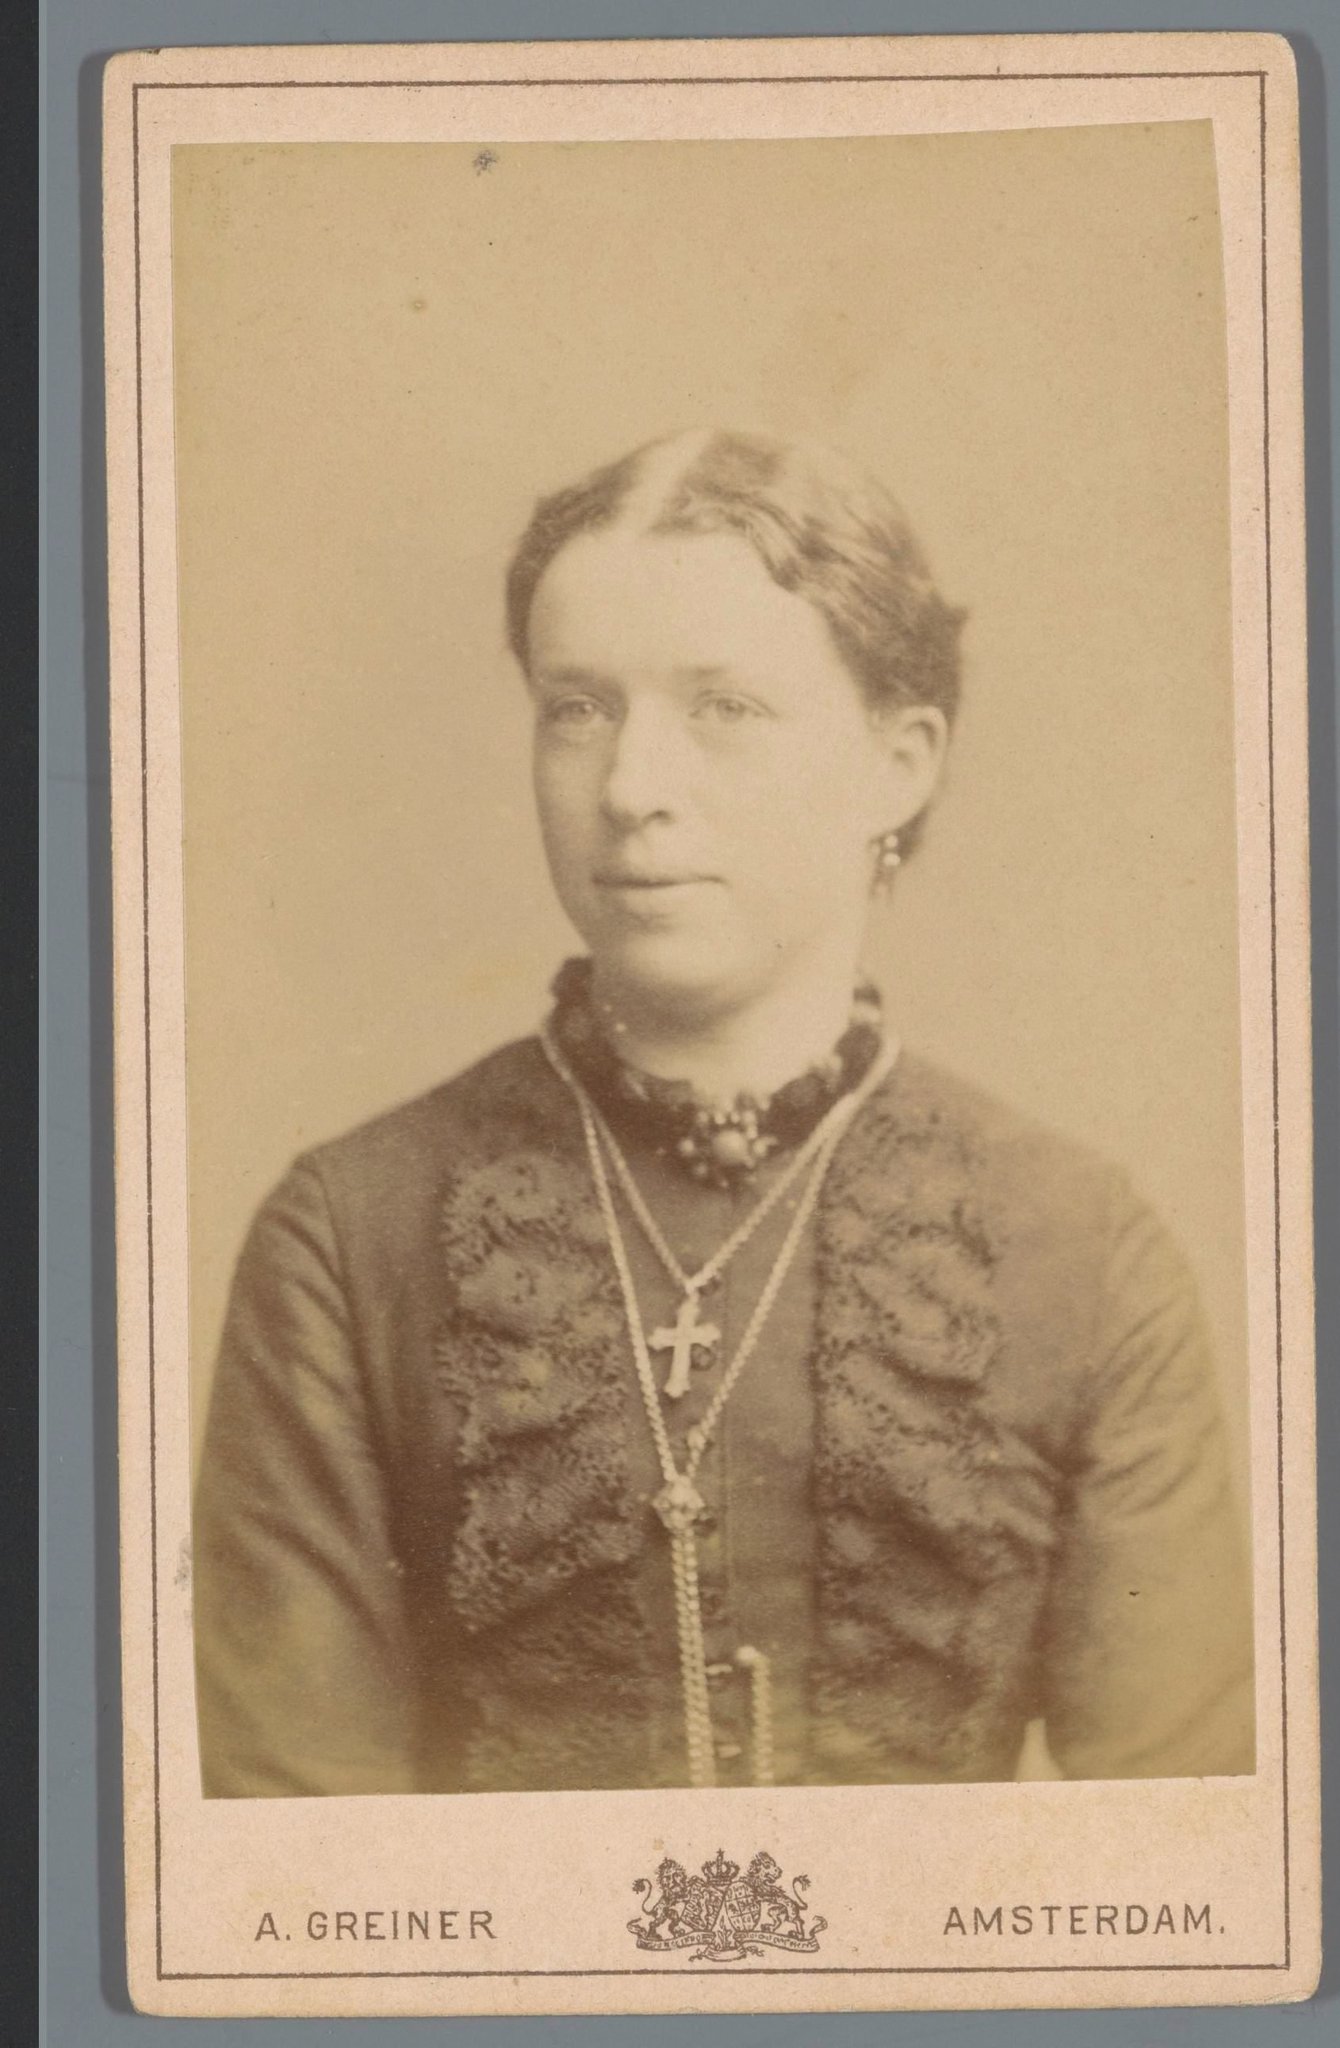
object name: photograph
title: Portret van een onbekende jonge vrouw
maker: albert greiner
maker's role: fotograaf, fotostudio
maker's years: 1833-1890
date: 1883-1889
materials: cardboard, paper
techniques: albumen print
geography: amsterdam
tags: adolescent, young woman, maiden, anonymous historical person portrayed, amsterdam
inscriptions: inscription: ‘Albert Greiner/ Kon-Ned-Hof-Photograaf/ Amsterdam/ Damrak 24./ Specialiteit in Vergrootingen.’, inscription: ‘A. Greiner Amsterdam.’